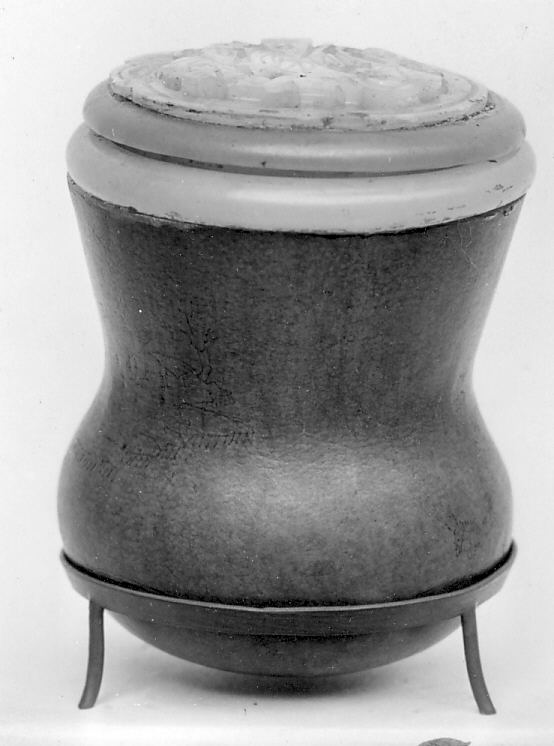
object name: cricket cage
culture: chinese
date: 1701-1900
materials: jade